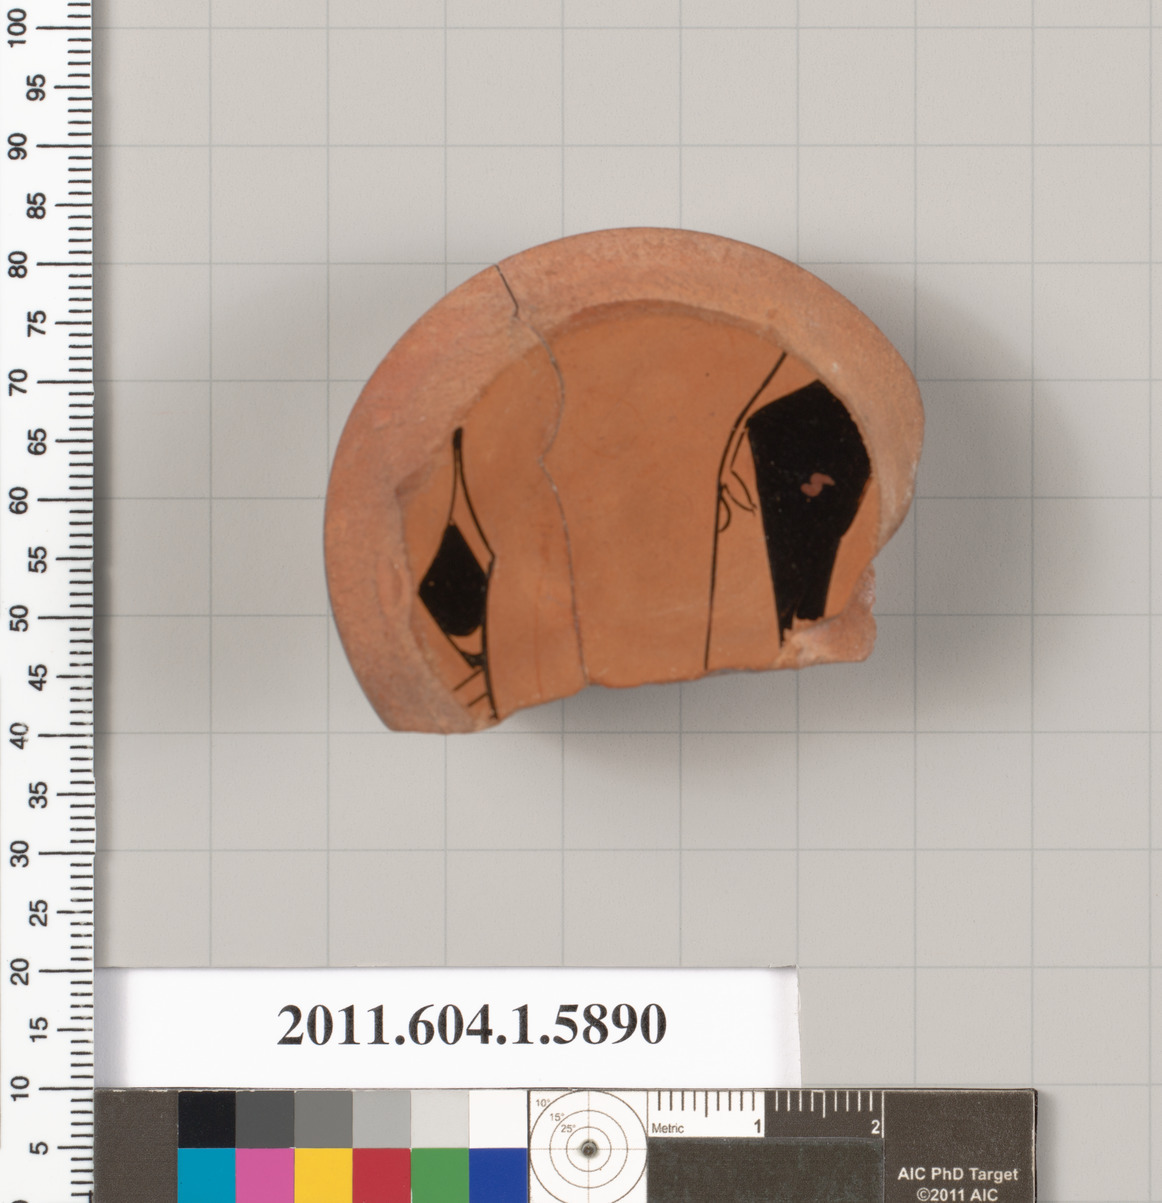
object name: kylix fragment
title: Terracotta fragment of a kylix (drinking cup)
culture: greek, attic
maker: epiktetos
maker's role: artist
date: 520-510 BCE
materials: terracotta